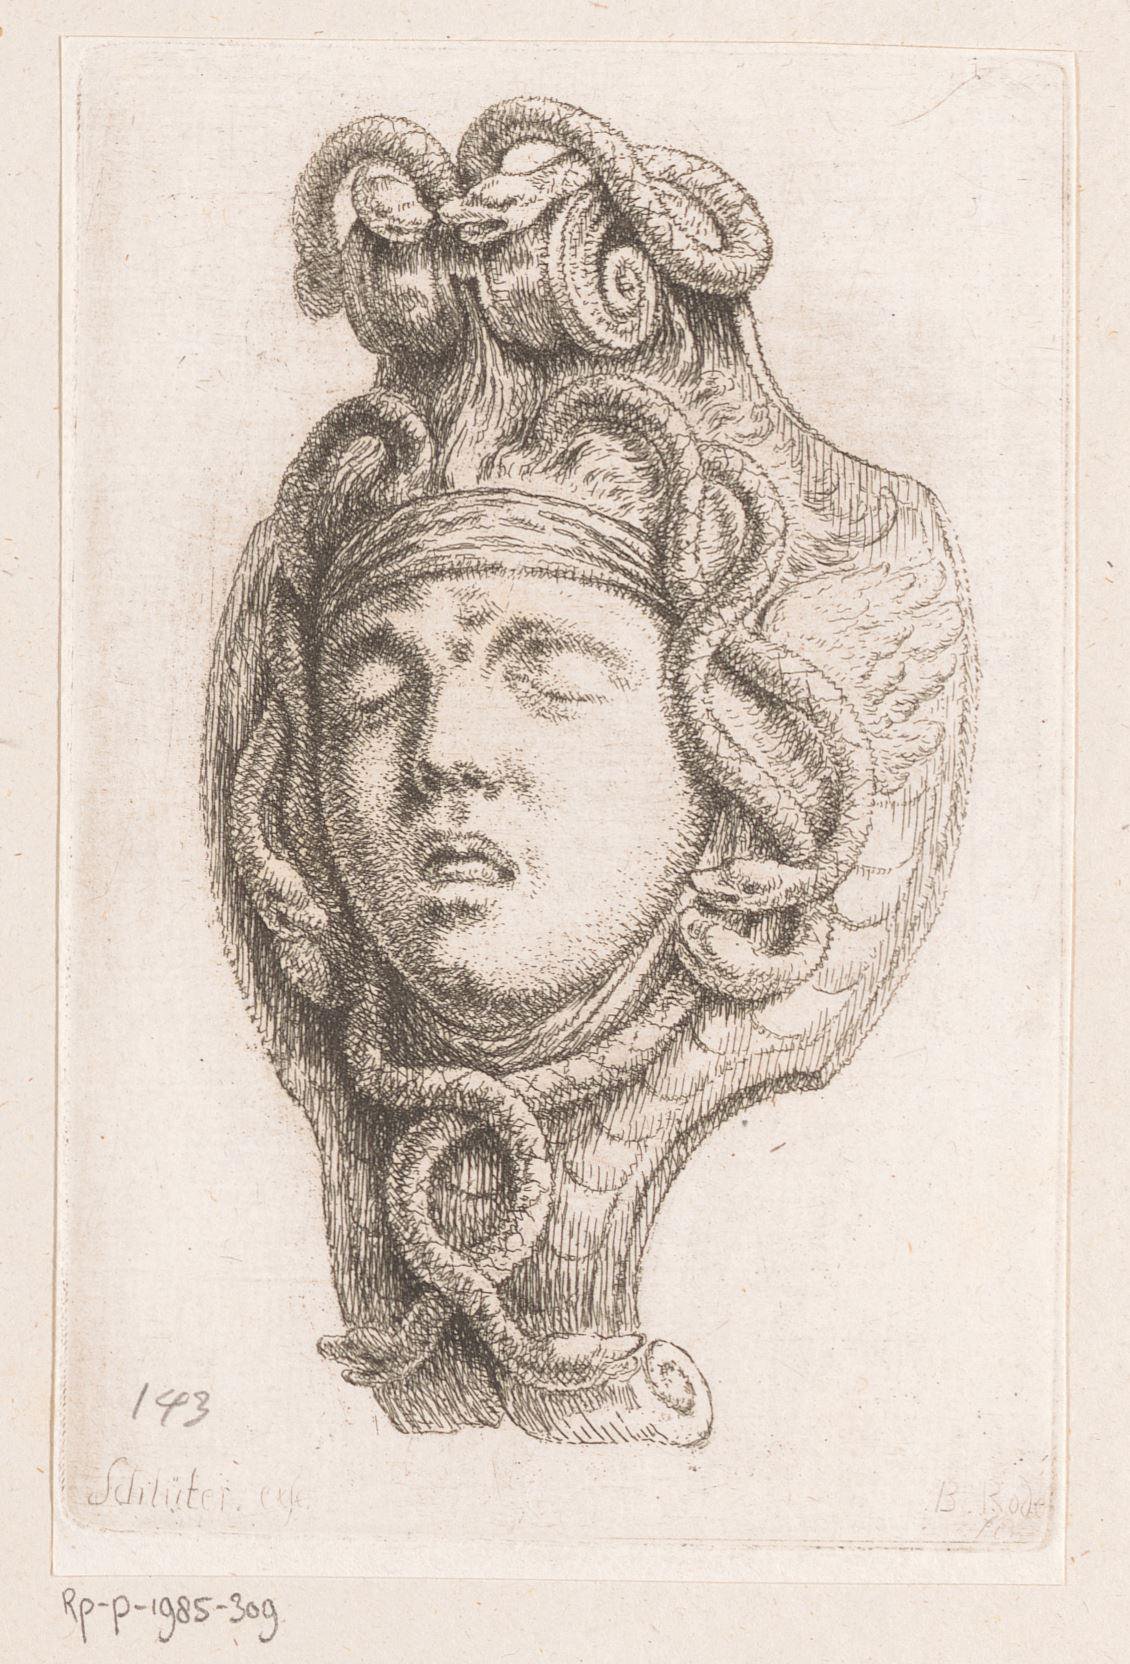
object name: print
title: Mascarons en helmen van het Zeughaus te Berlijn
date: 1759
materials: paper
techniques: etching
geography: berlin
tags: mask, mascaron ~ ornament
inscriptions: collector's mark: Lugt 2760, collector's mark: Lugt 2228